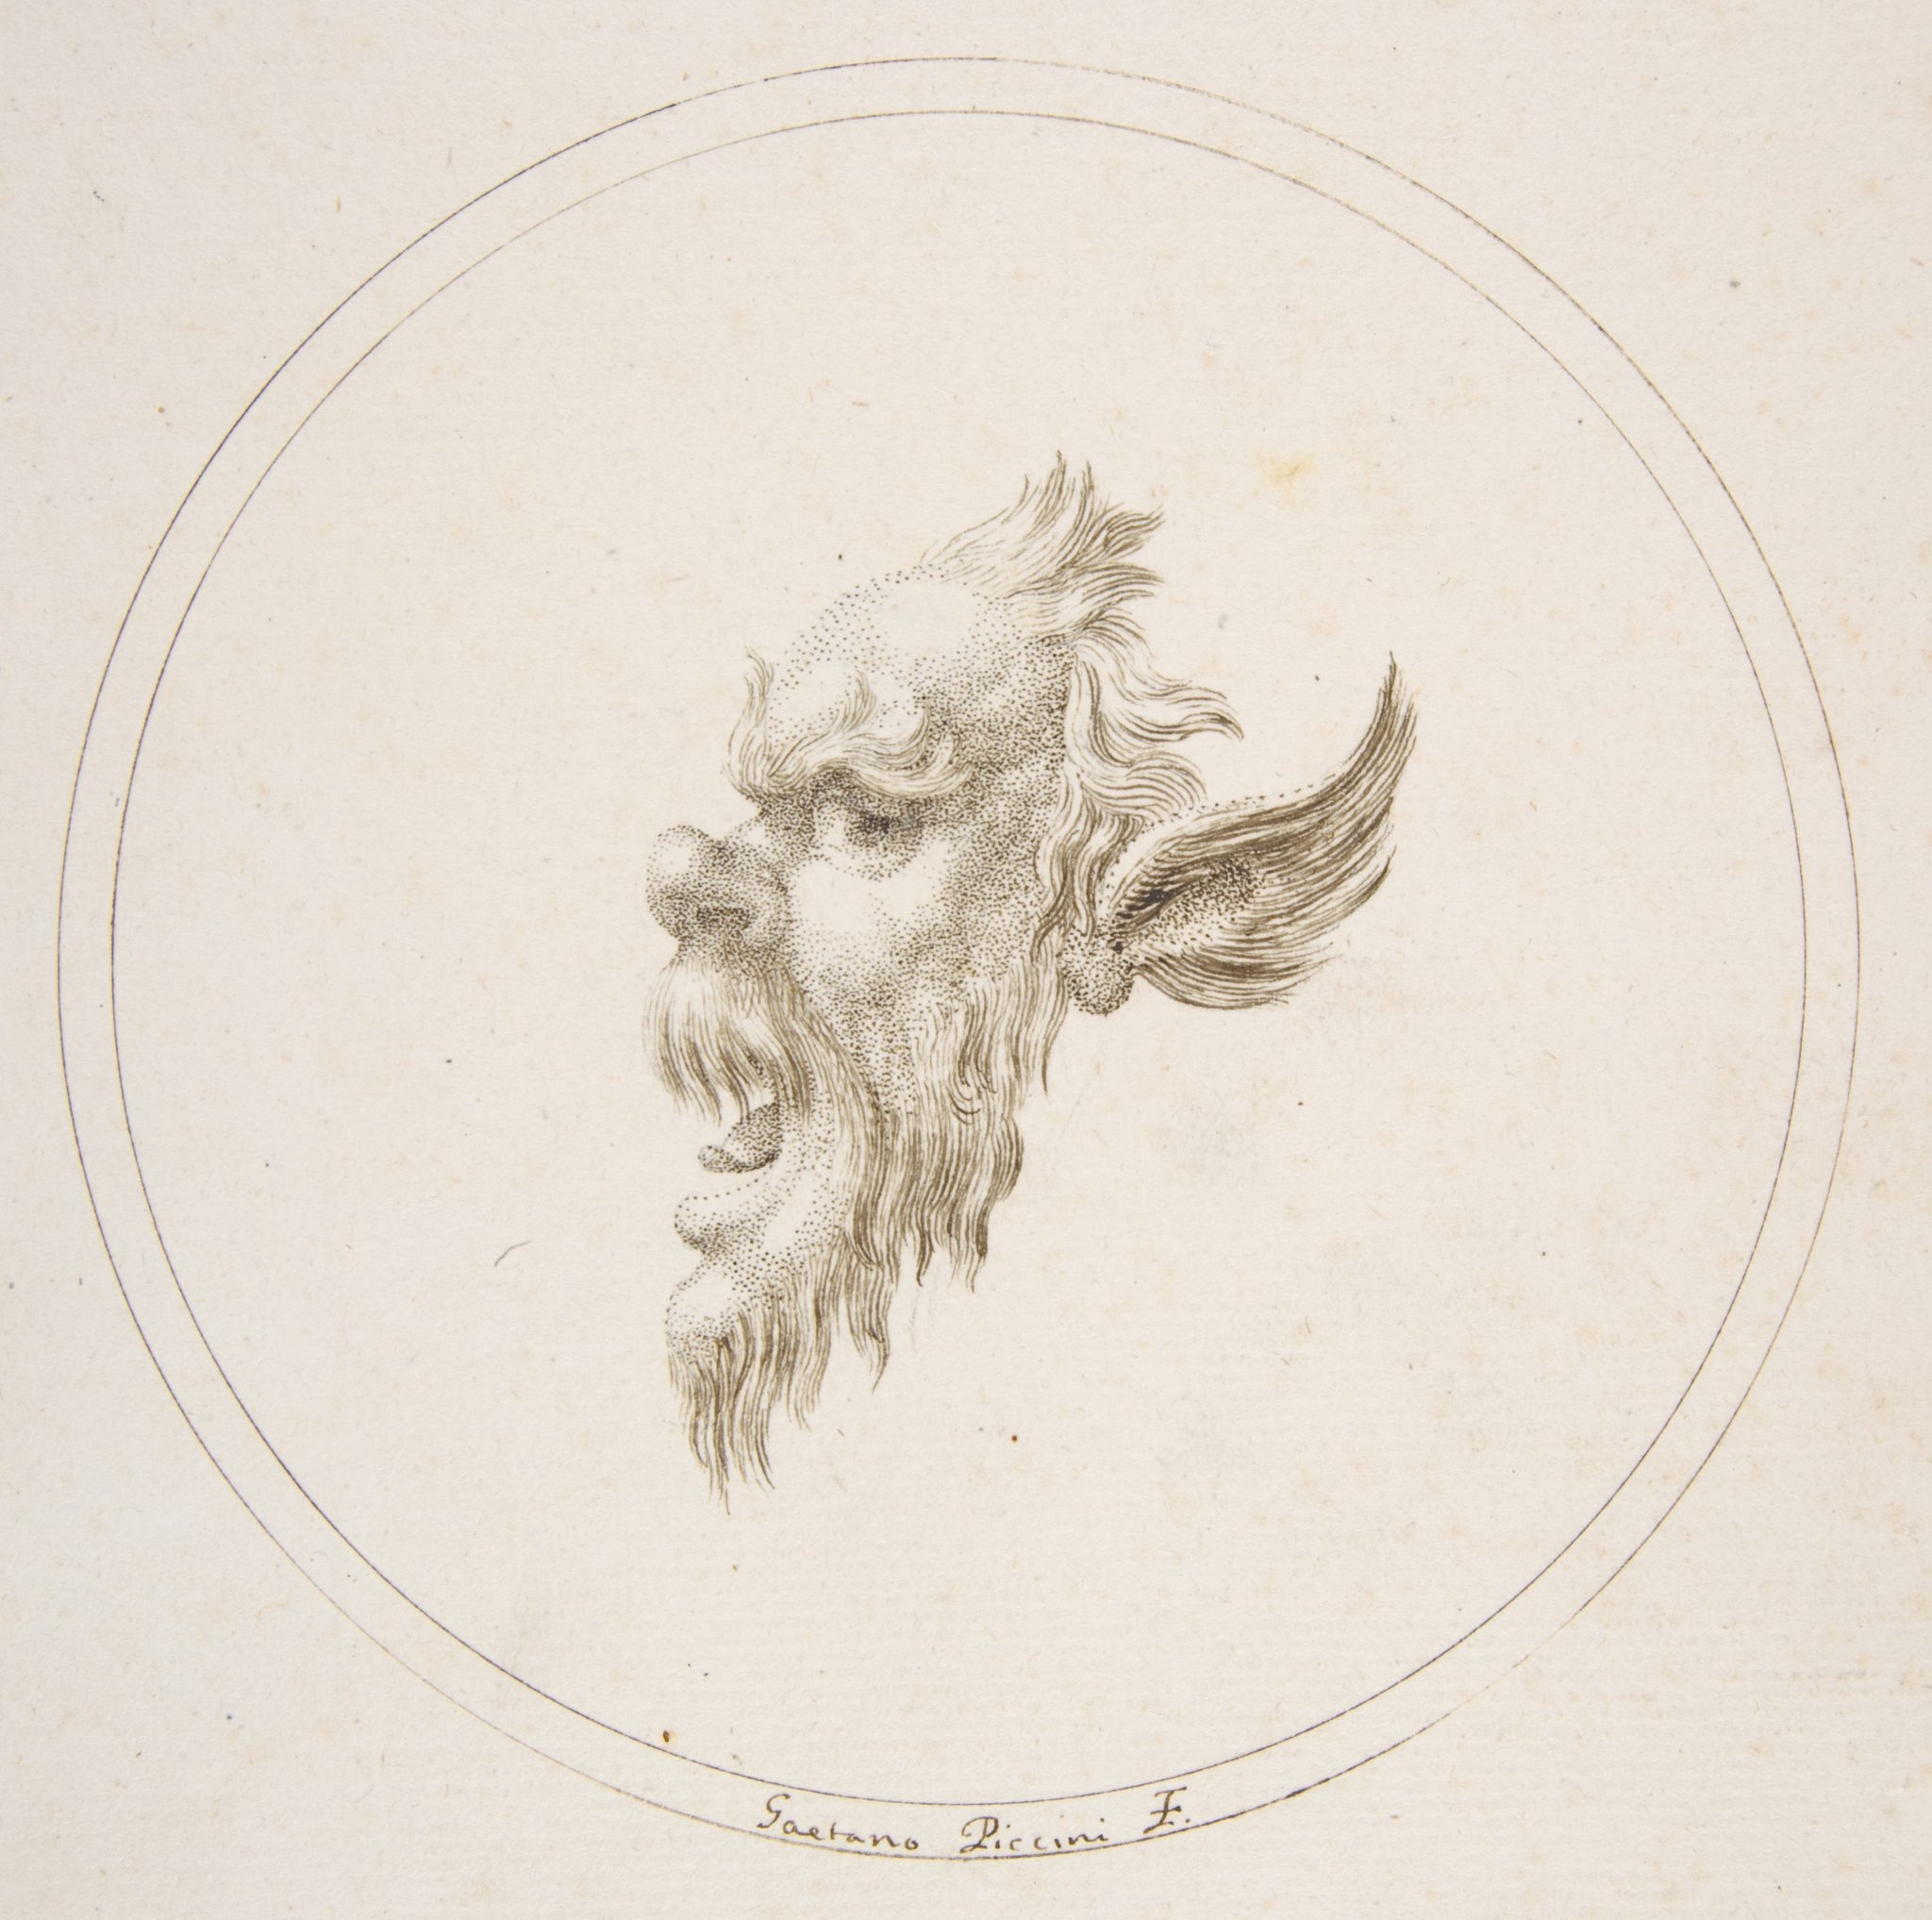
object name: drawing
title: Small Grotesque Head Looking to the Left Within a Circle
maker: gaetano piccini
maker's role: artist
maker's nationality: italian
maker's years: 1710-1730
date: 1727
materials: ink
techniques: pen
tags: heads,men